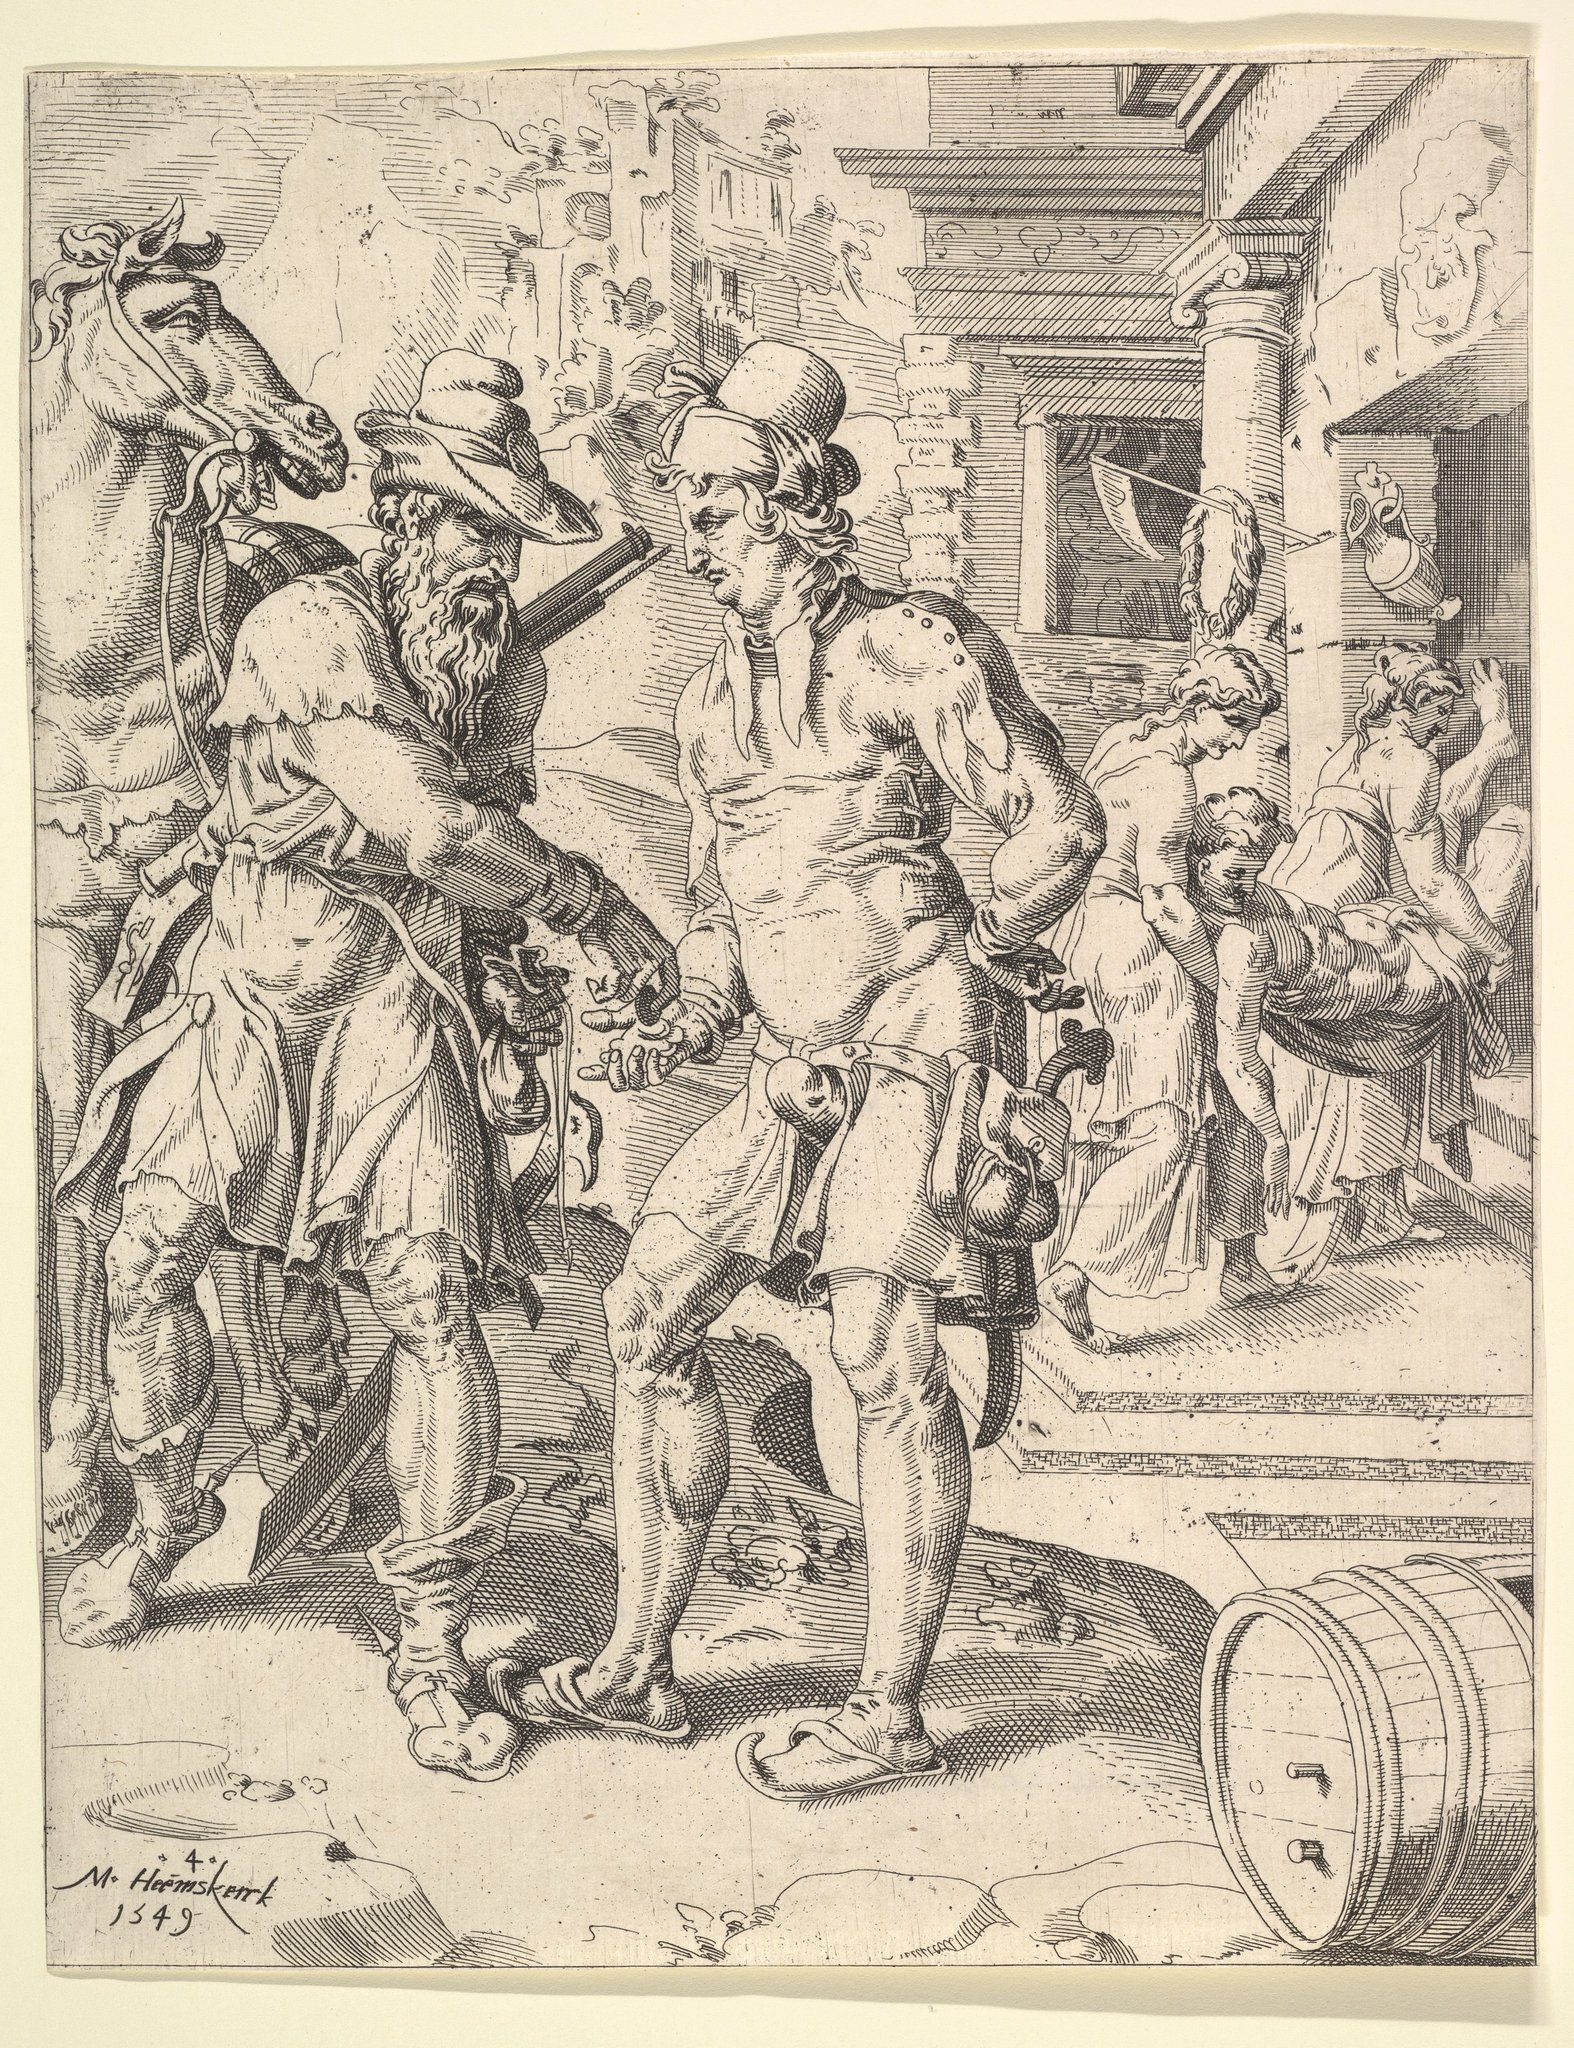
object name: print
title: The Parable of the Good Samaritan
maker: maarten van heemskerck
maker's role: artist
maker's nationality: netherlandish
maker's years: 1498-1574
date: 1549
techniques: etching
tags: illness,men,women,horses